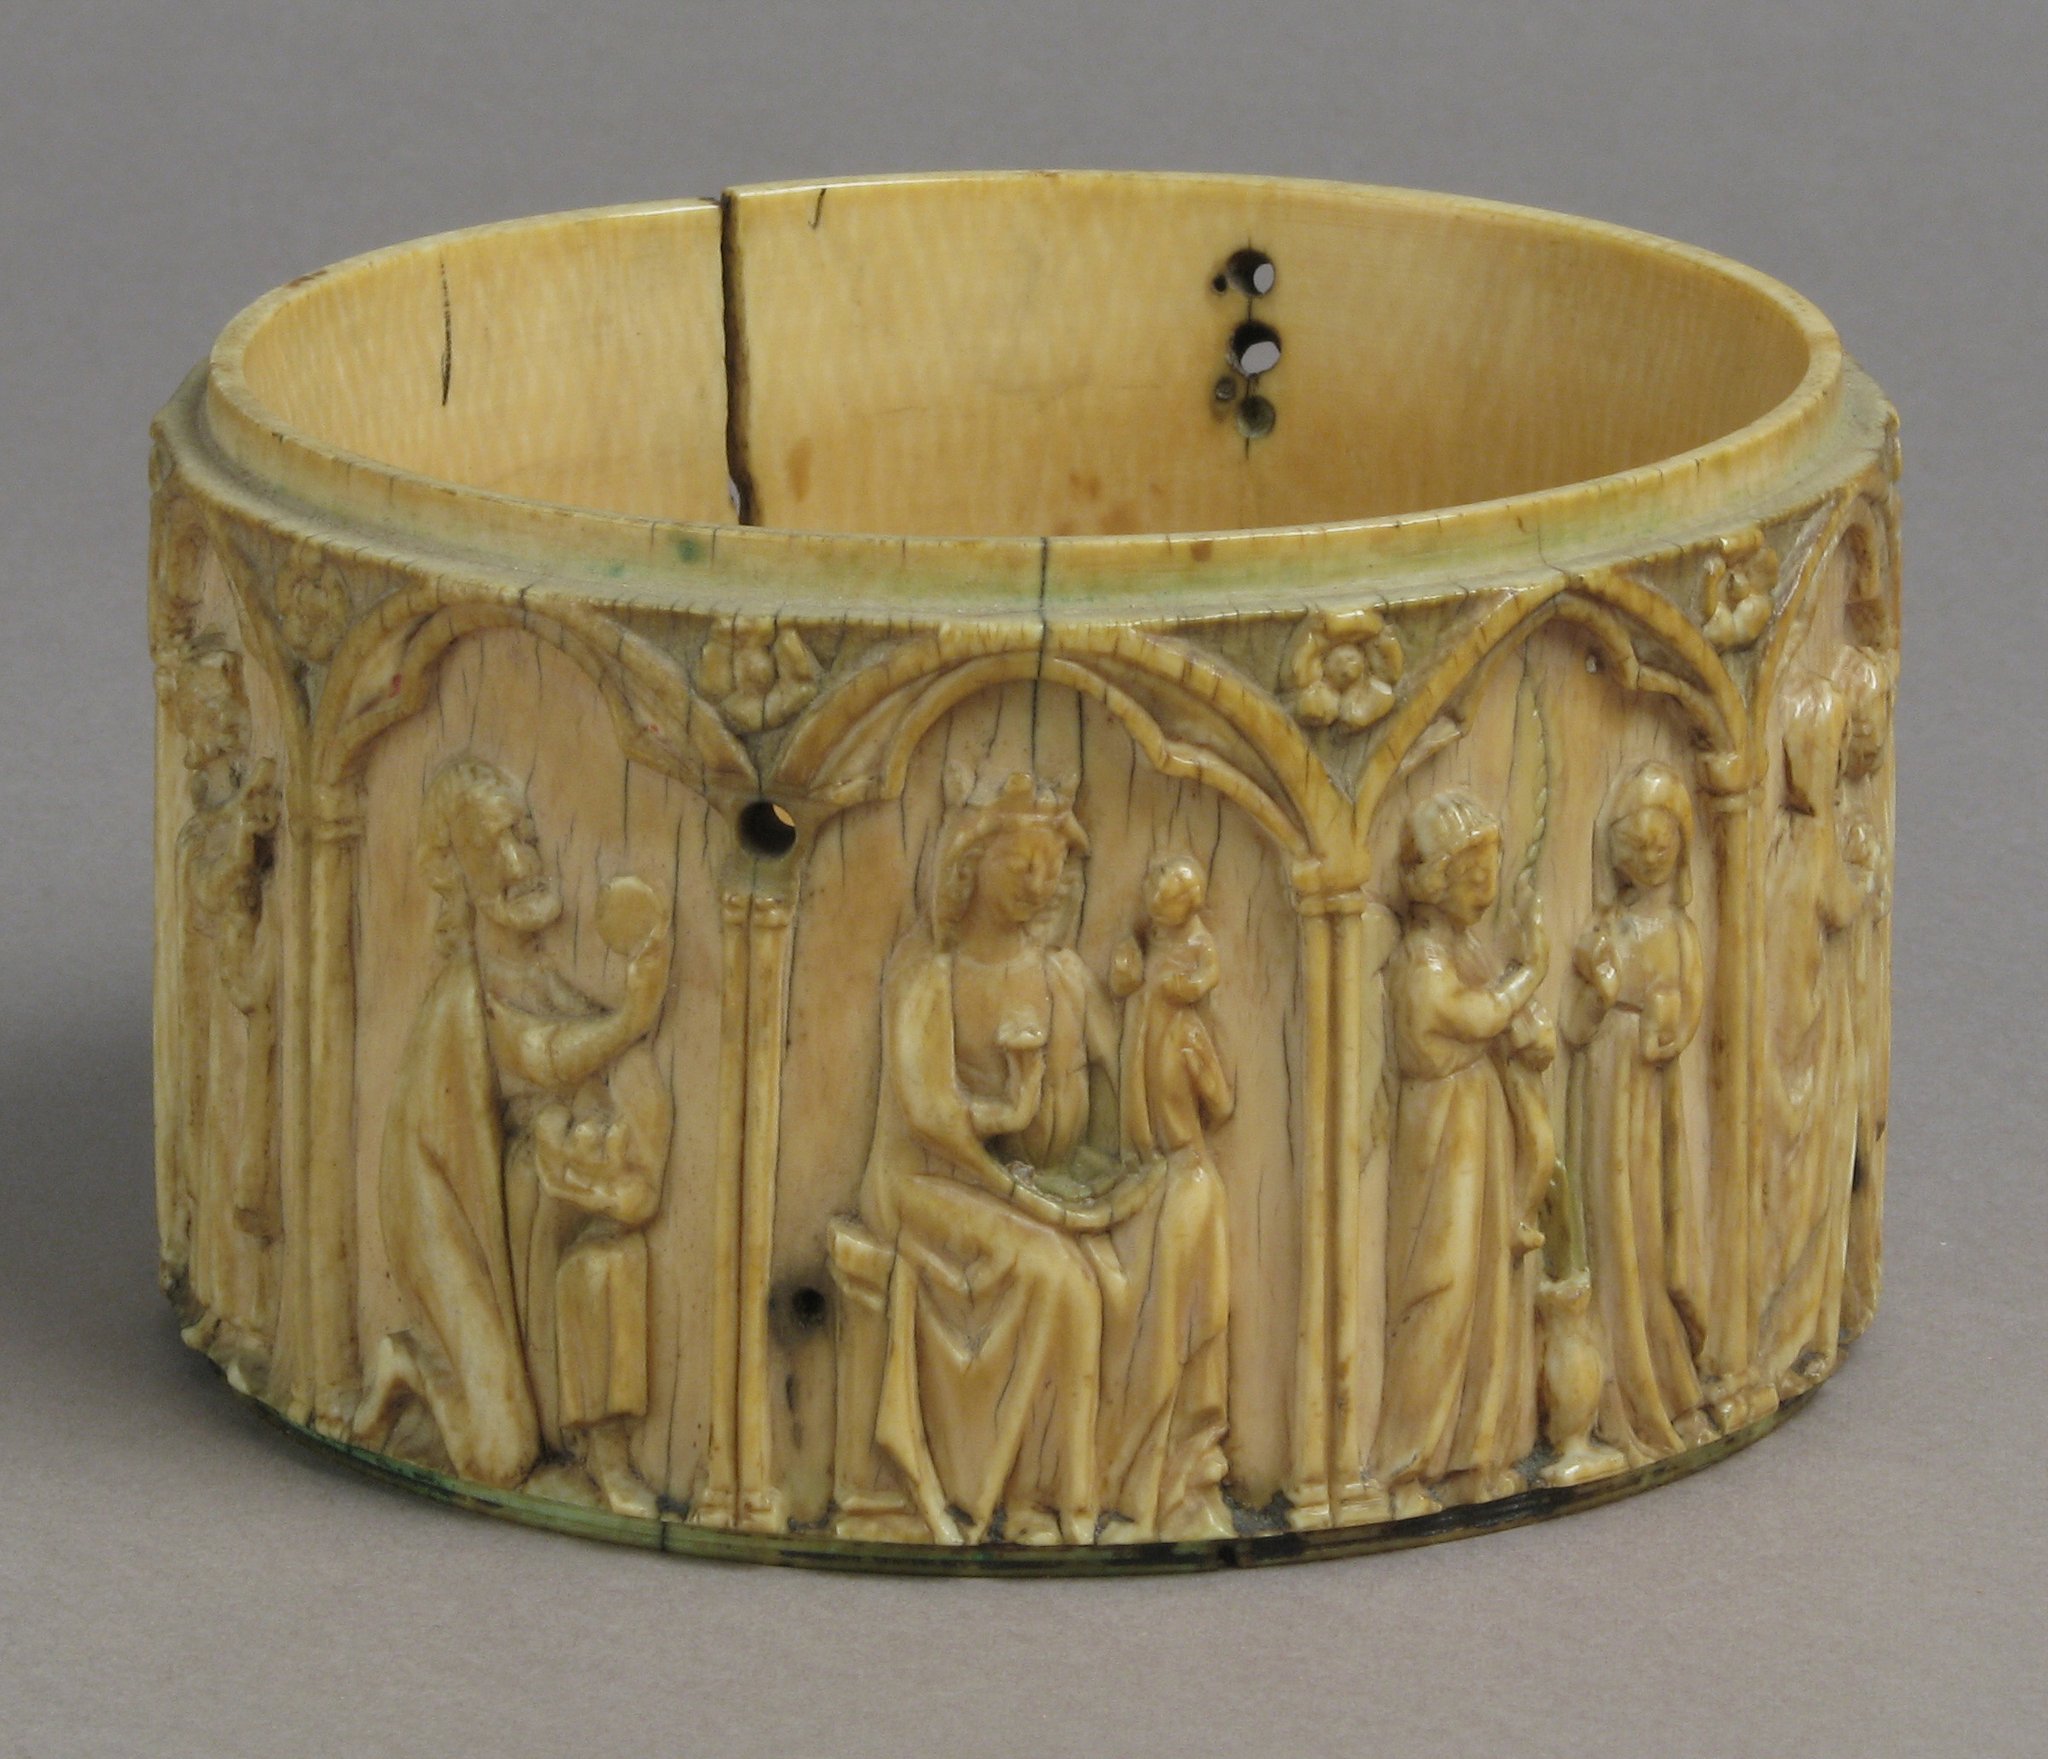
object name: box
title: Circular Box (Pyxis) with Scenes from the Infancy of Jesus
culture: french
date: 1301-1333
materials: ivory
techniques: polychromy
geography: france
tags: human figures